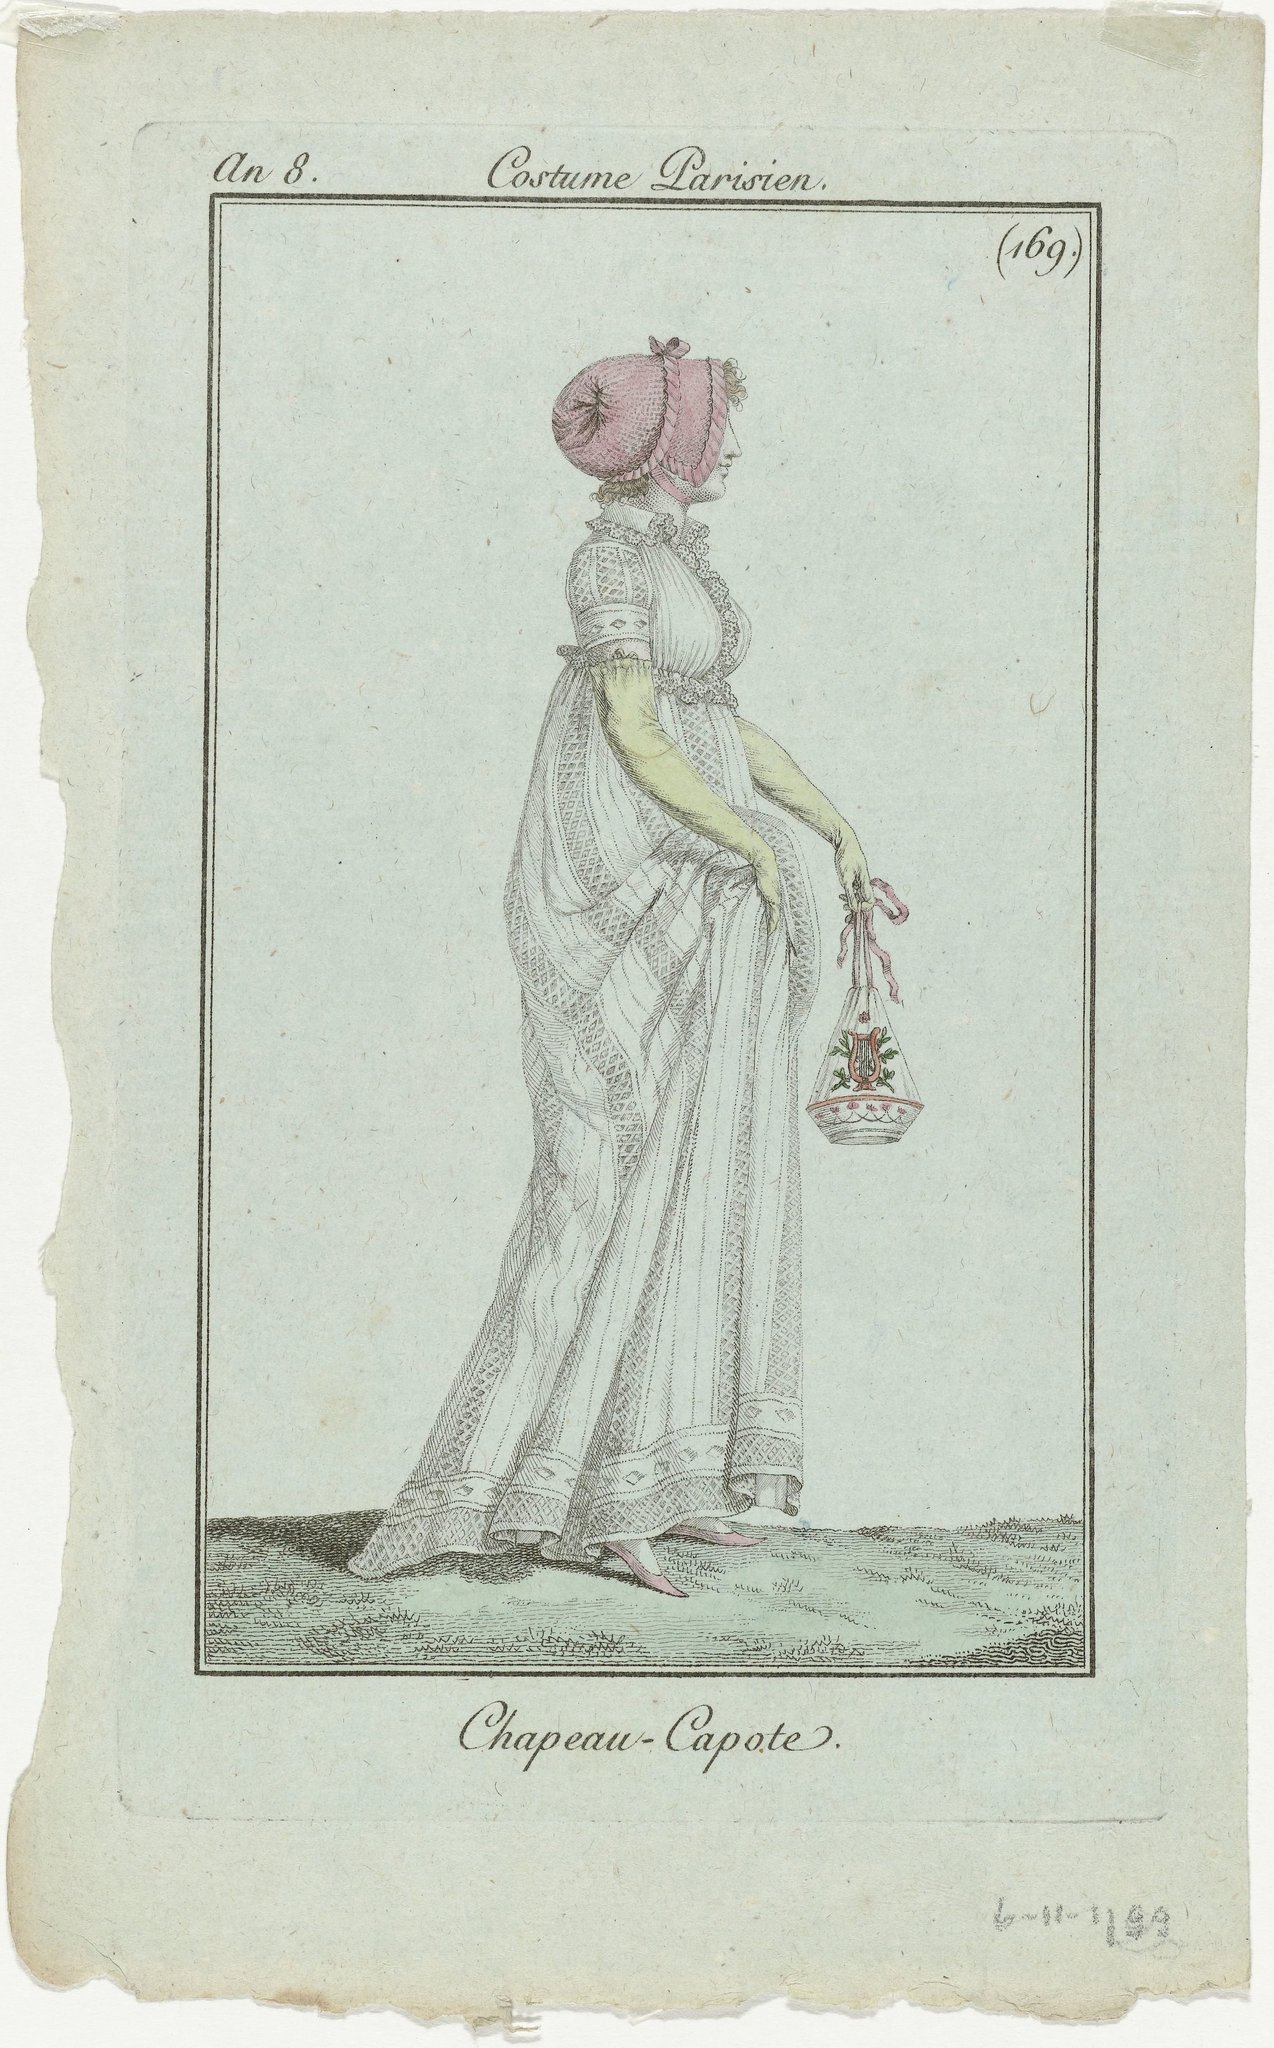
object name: fashion print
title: Journal des Dames et des Modes, Costume Parisien, 6 novembre 1799, An 8 (169) : Chapeau - Capote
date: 1799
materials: paper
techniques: engraving, hand coloring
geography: paris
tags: head-gear (capote) (+ women's clothes), gloves, mittens (long gloves) (+ women's clothes), clothing for the upper part of the body: blouse (+ women's clothes), bag (reticule) (+ women's clothes), fashion plates, head-gear: hat (+ women's clothes), dress, gown (+ women's clothes)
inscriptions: title: ‘Costume Parisien.’, caption: ‘Chapeau-Capote’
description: Vrouw, lopend naar rechts, op het hoofd een 'Chapeau-Capote'. Zij draagt een canezou op een gestreepte japon met korte mouwen. In de linkerhand een reticule met een versiering van een harp en bladeren. Verdere accessoires: lange handschoenen, platte schoenen met puntige neuzen. De prent maakt deel uit van het modetijdschrift Journal des Dames et des Modes, uitgegeven door Pierre de la Mésangère, Parijs, 1797-1839.